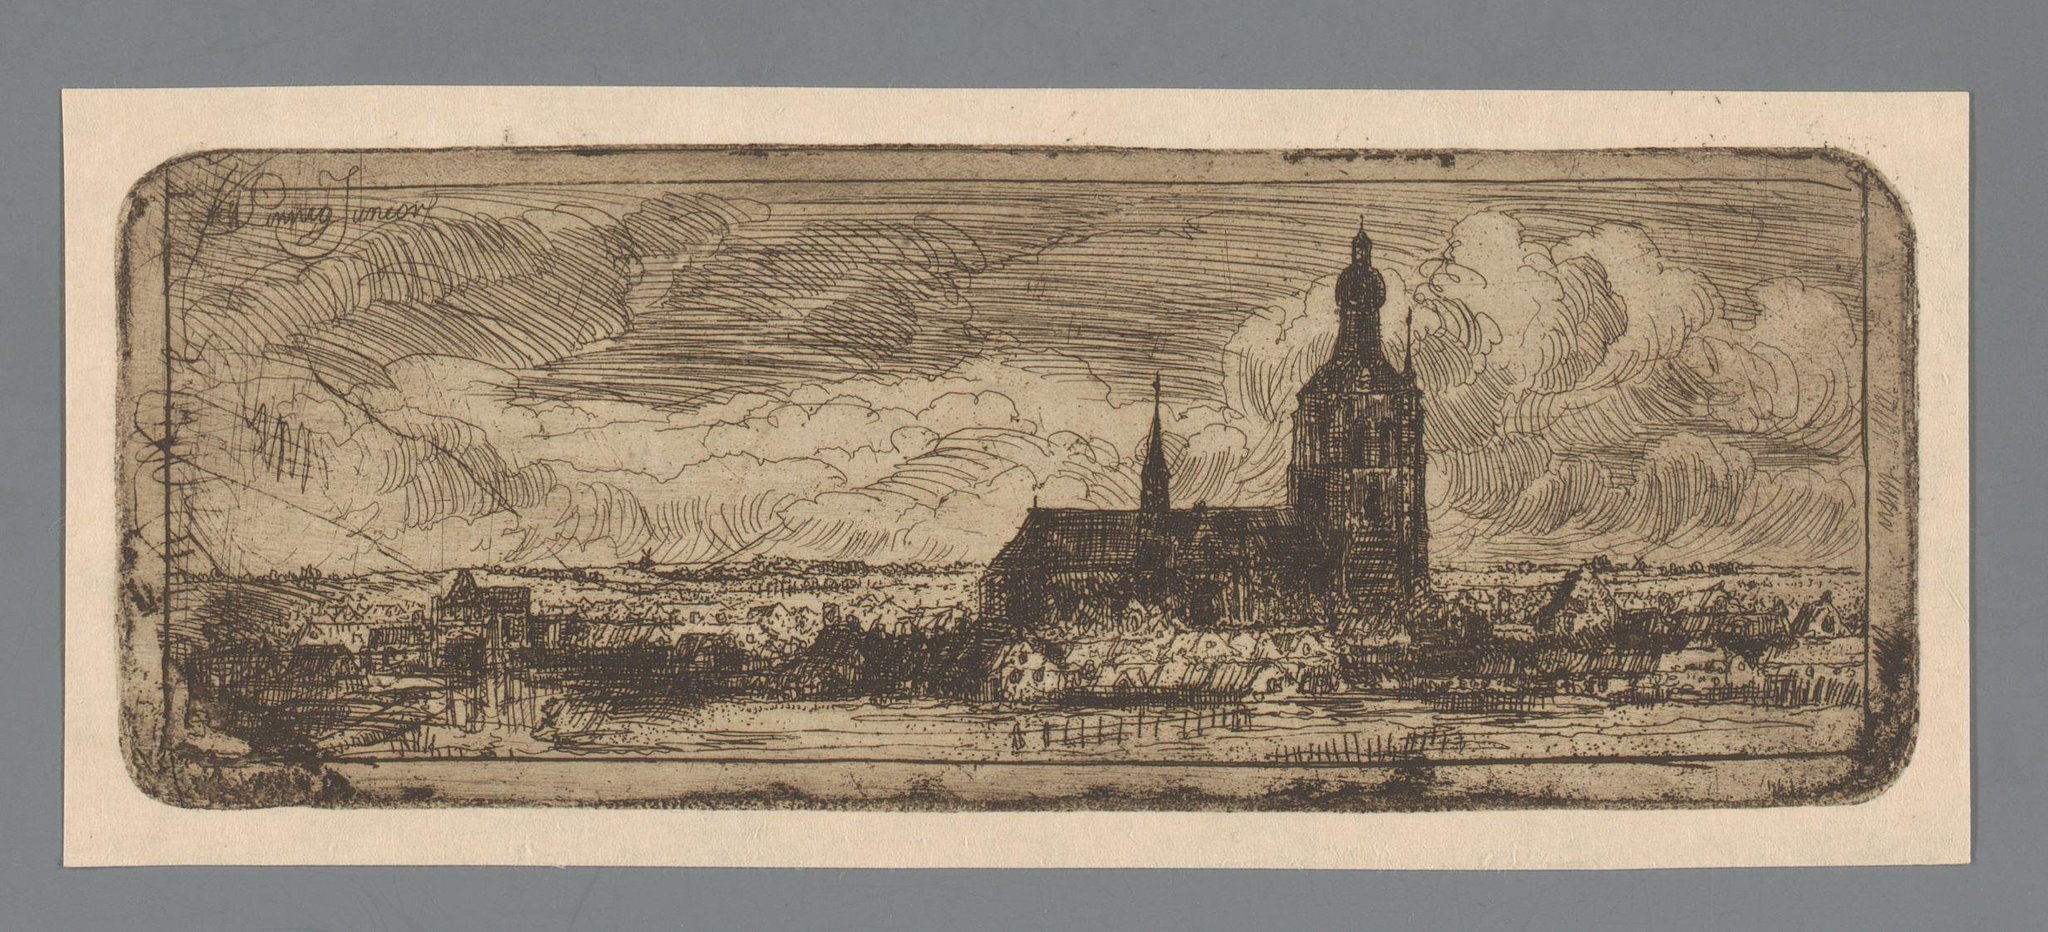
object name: print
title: Gezicht op een kerkgebouw in een stad aan een rivier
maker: willem linnig (ii)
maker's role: print maker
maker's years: 1842-1890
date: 1852-1890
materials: paper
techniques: etching, intaglio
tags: city-view in general; 'veduta', church (exterior)